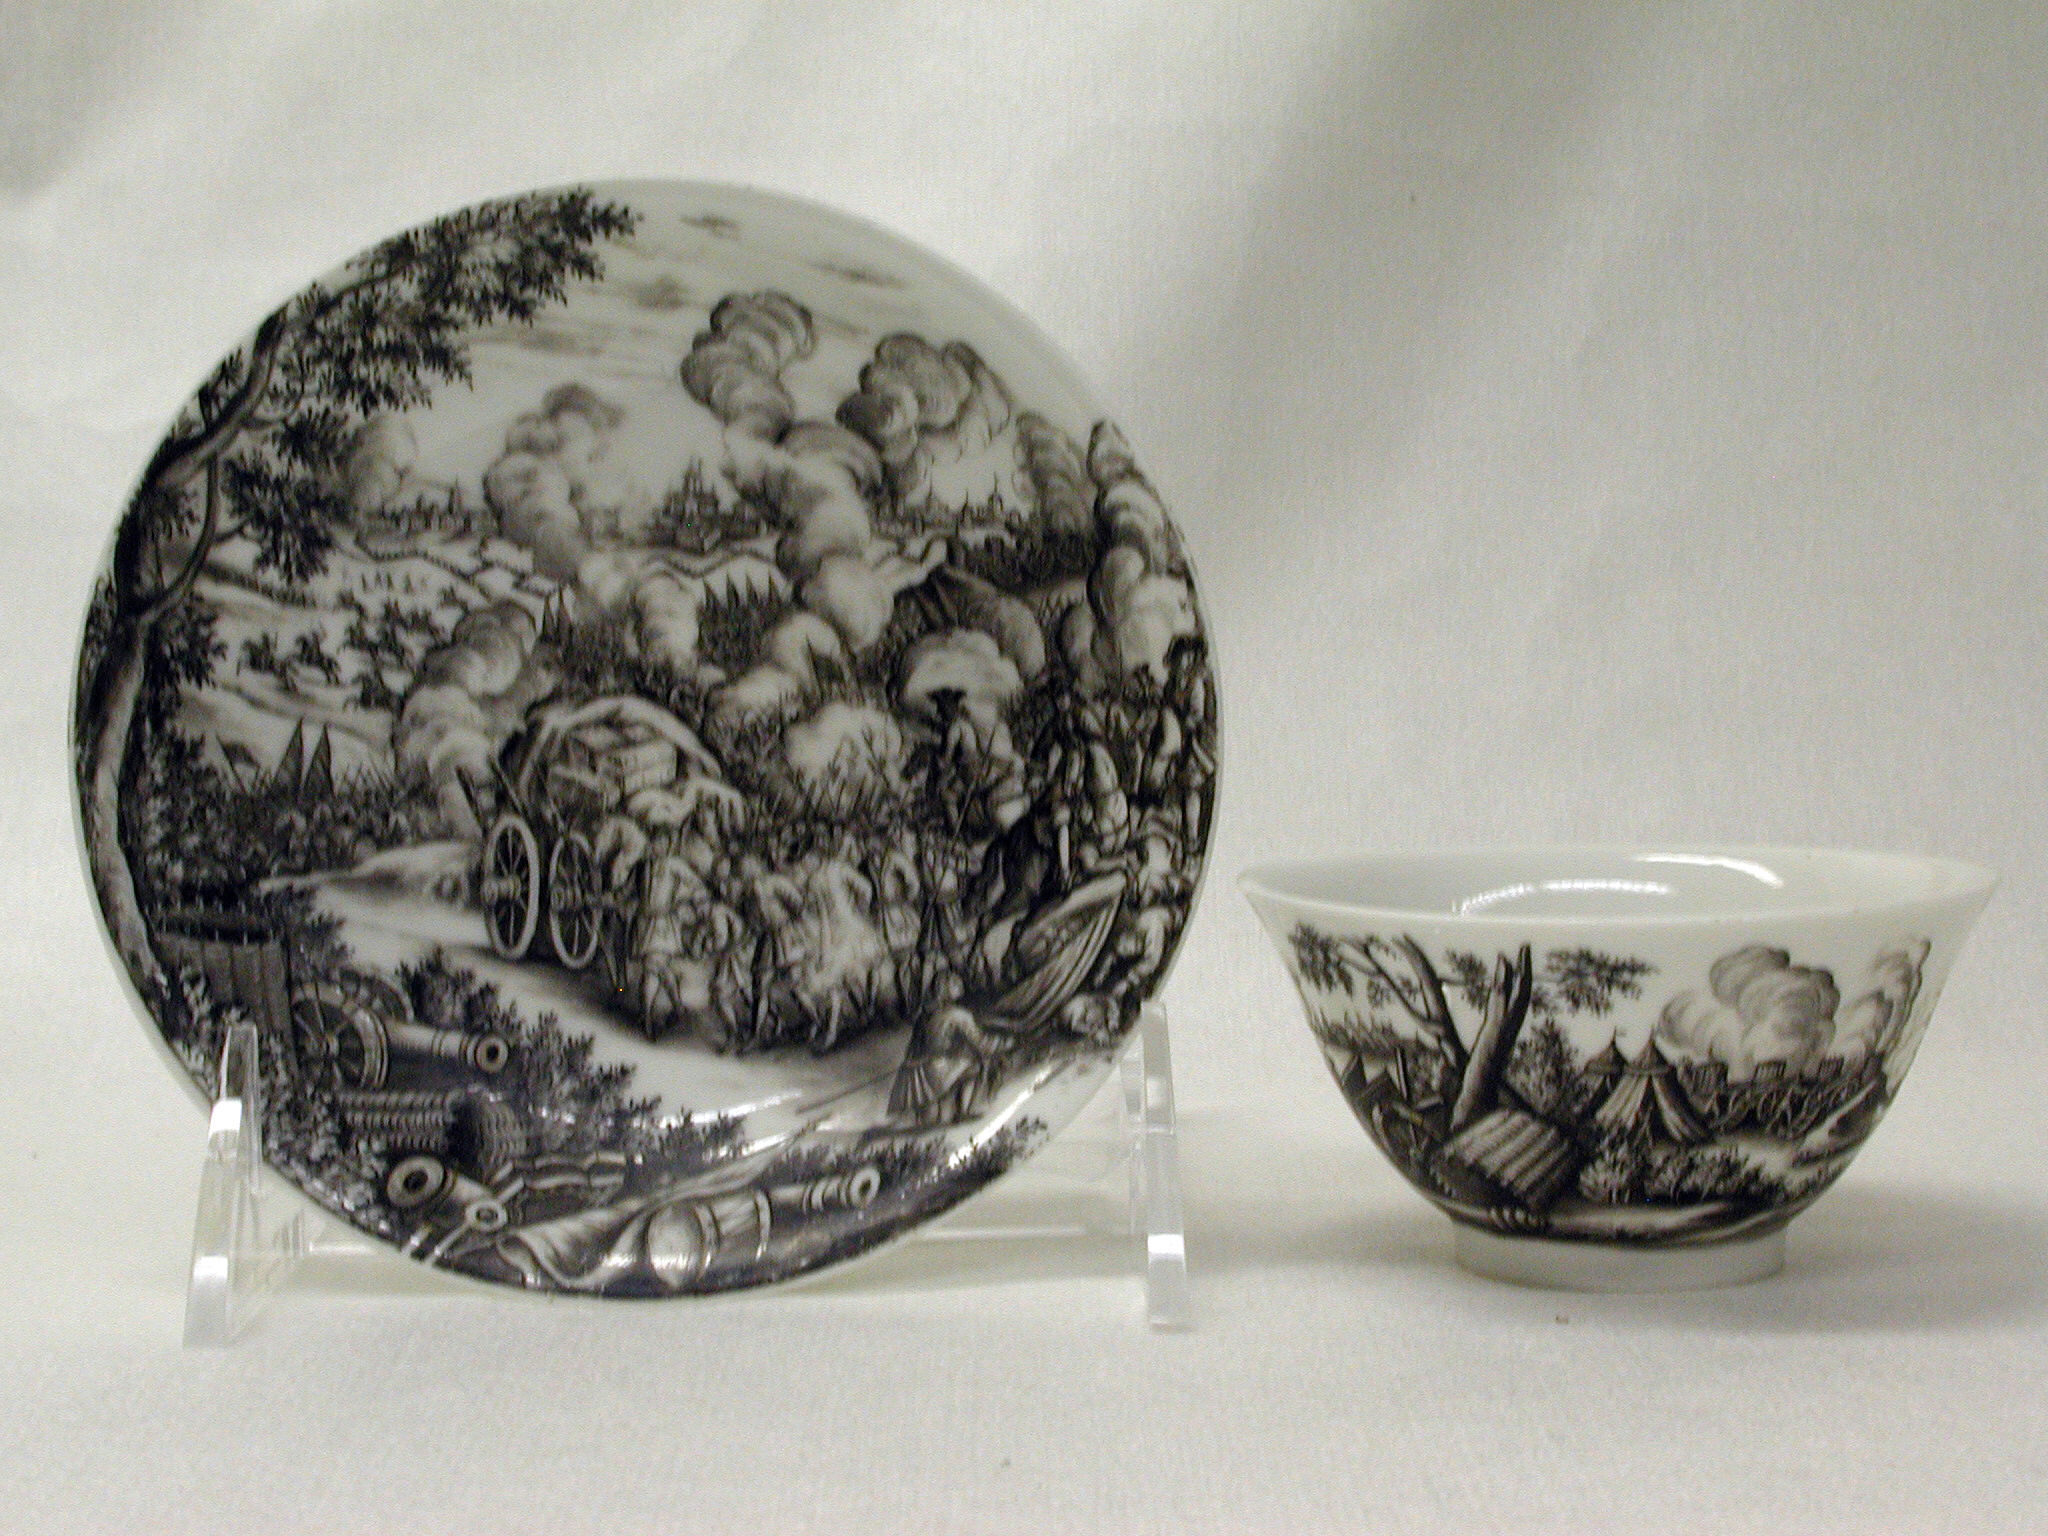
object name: teabowl and saucer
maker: meissen manufactory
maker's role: manufactory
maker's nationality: german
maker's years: 1710-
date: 1720-1725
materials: hard paste porcelain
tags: battles,cannons,trees